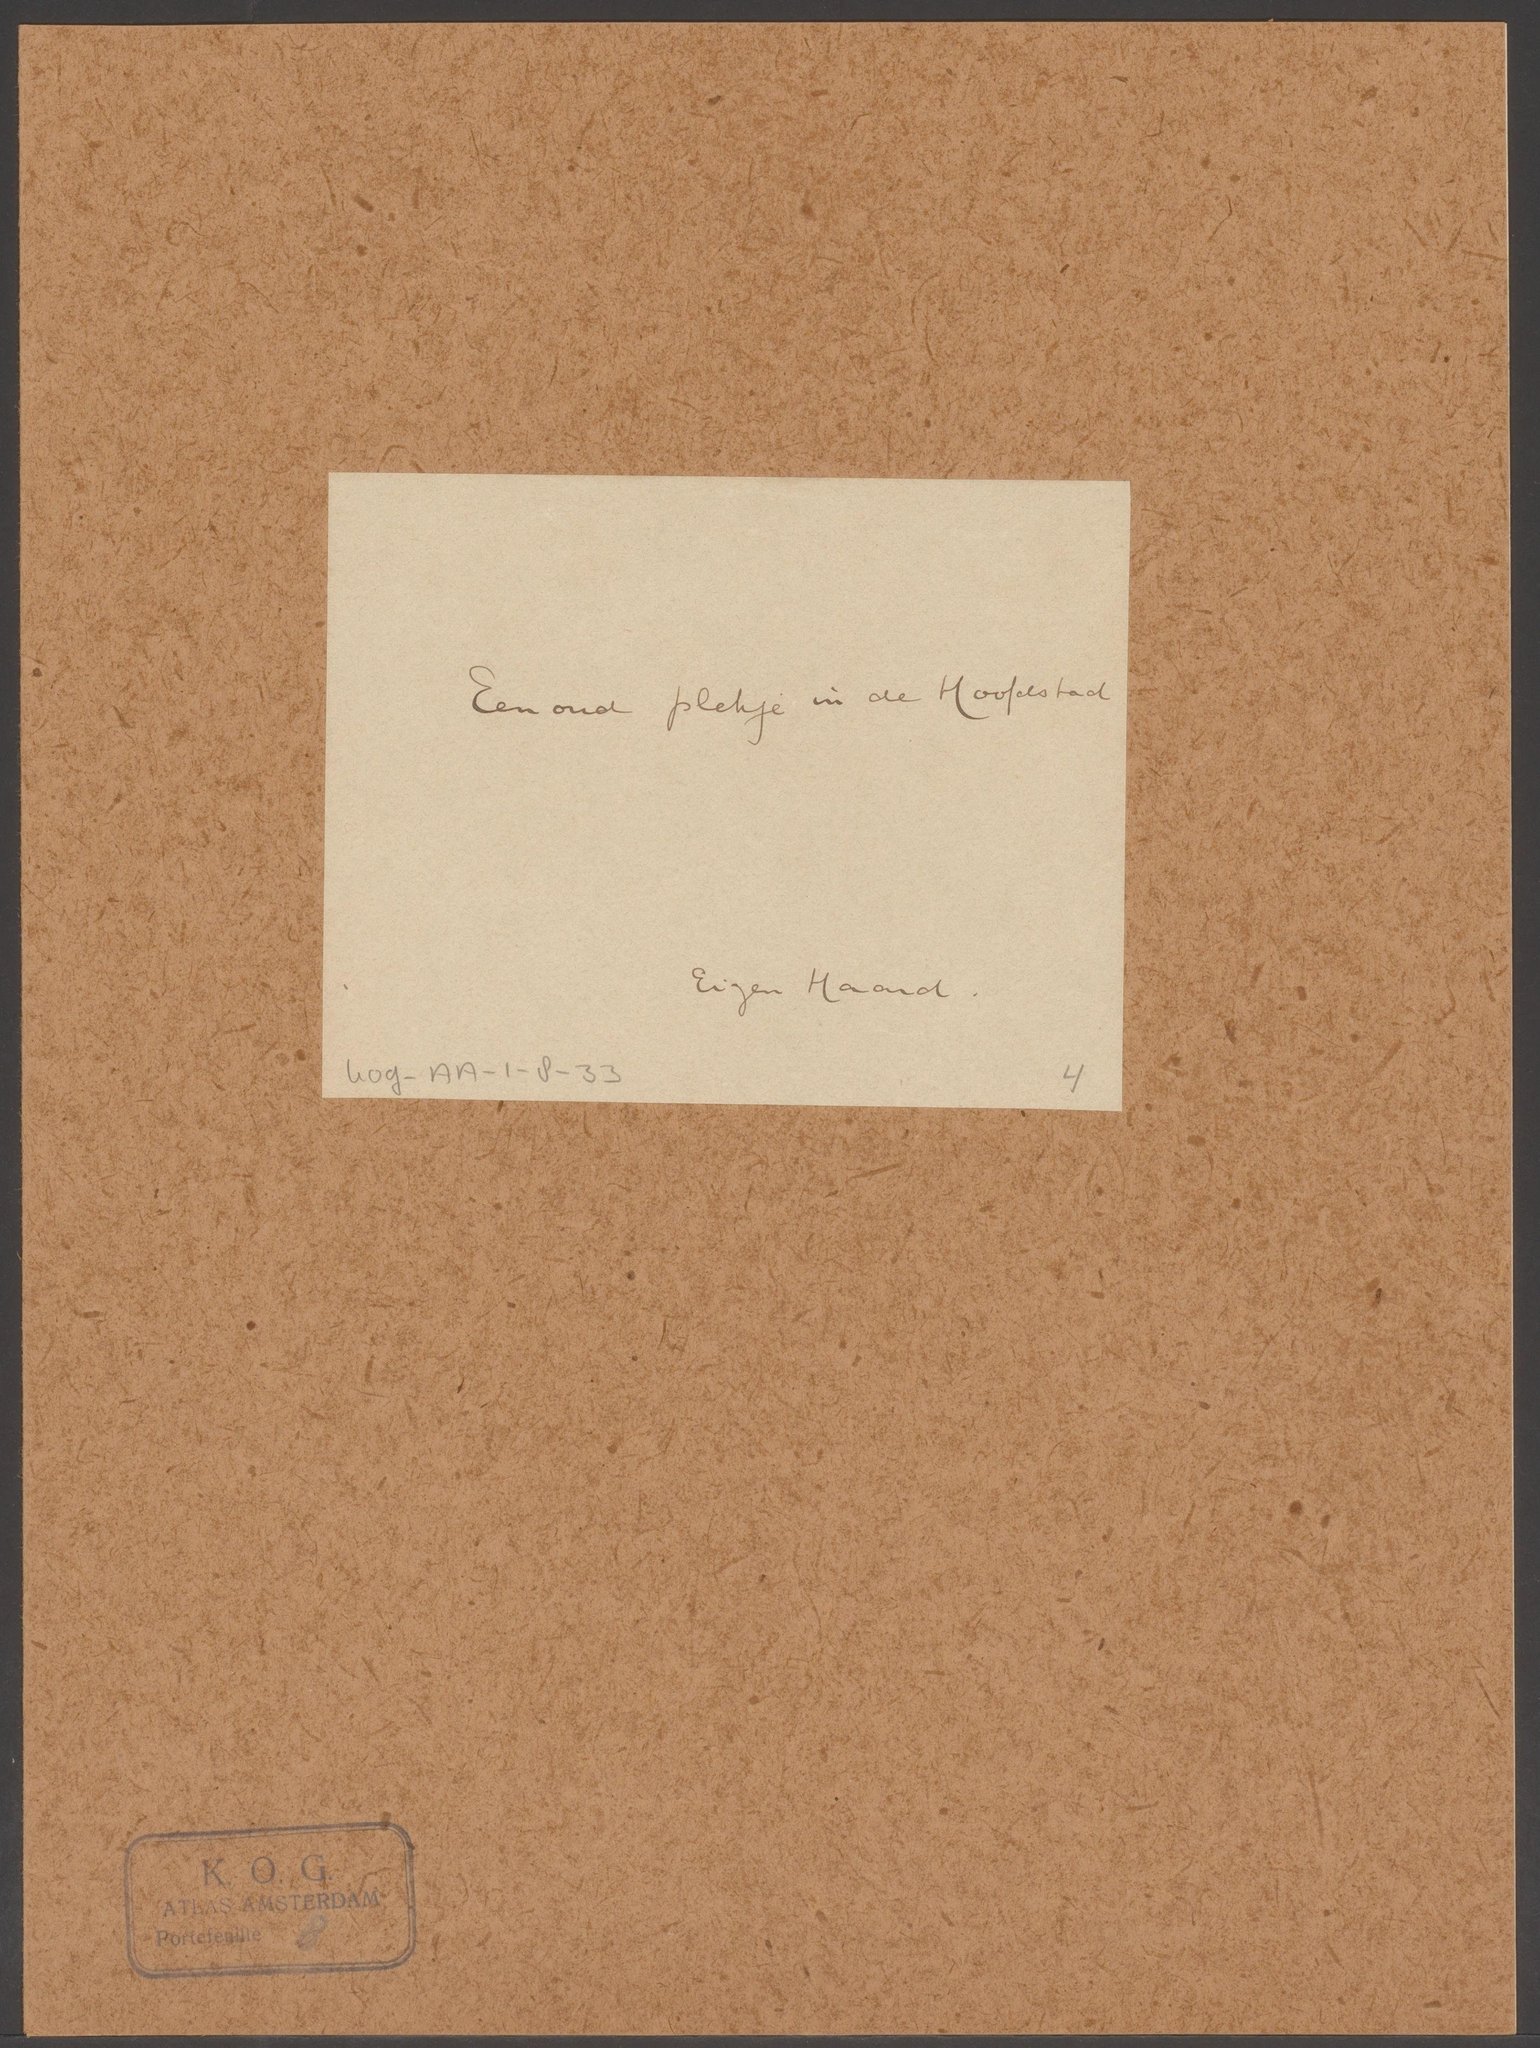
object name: magazine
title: Bladzijden uit het tijdschrift Eigen Haard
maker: Anonymous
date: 1906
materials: glue, paper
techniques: letterpress printing, line block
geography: haarlem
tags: damage (to a ship), weekly, monthly, magazine, etc., canal, the usual house or row of houses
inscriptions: collector's mark: ‘8’ Lugt 1641b, inscription: ‘Een oud plekje in de Hoofdstad / Eigen Haard’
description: Onderwerpsrubriek binnen de Atlas Amsterdam: Galerij Paleis voor Volksvlijt, Gebed zonder end, Geldersche Kade, Gravenstraat, Grimburgwal, Grimnessesluis, Groeneburgwal.